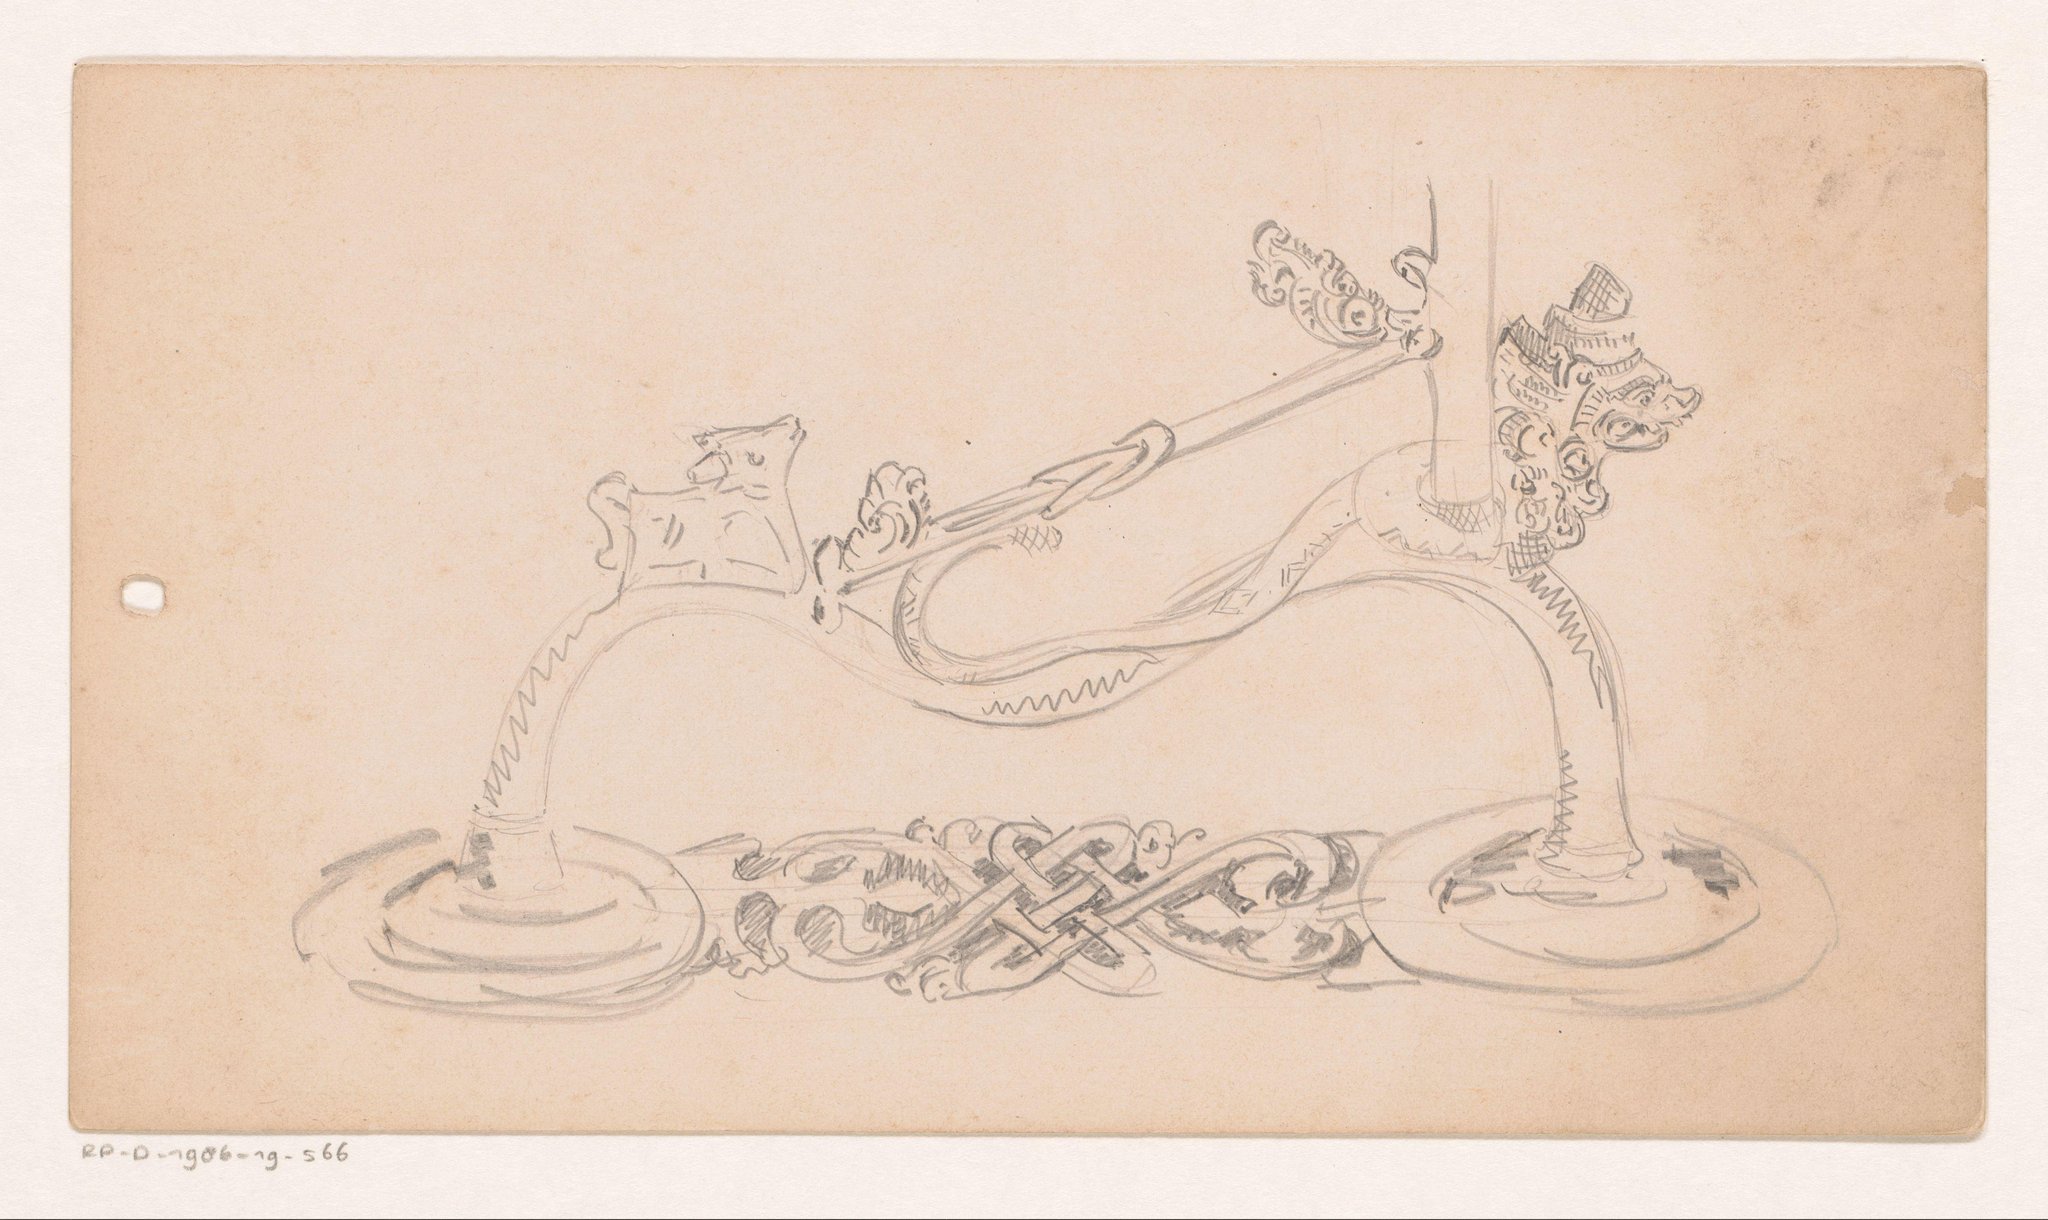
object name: drawing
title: Voorwerp versierd met vlechtwerk en ornamenten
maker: reinier willem petrus de vries (1874-1953)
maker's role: draughtsman, print maker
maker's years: 1874-1953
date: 1884-1952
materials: paper, pencil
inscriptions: inscription: ‘No 3005./ ROYAL BRISTOL. 50 bij 65 ctm. 50 KILO’, collector's mark: ‘R:MVS.’